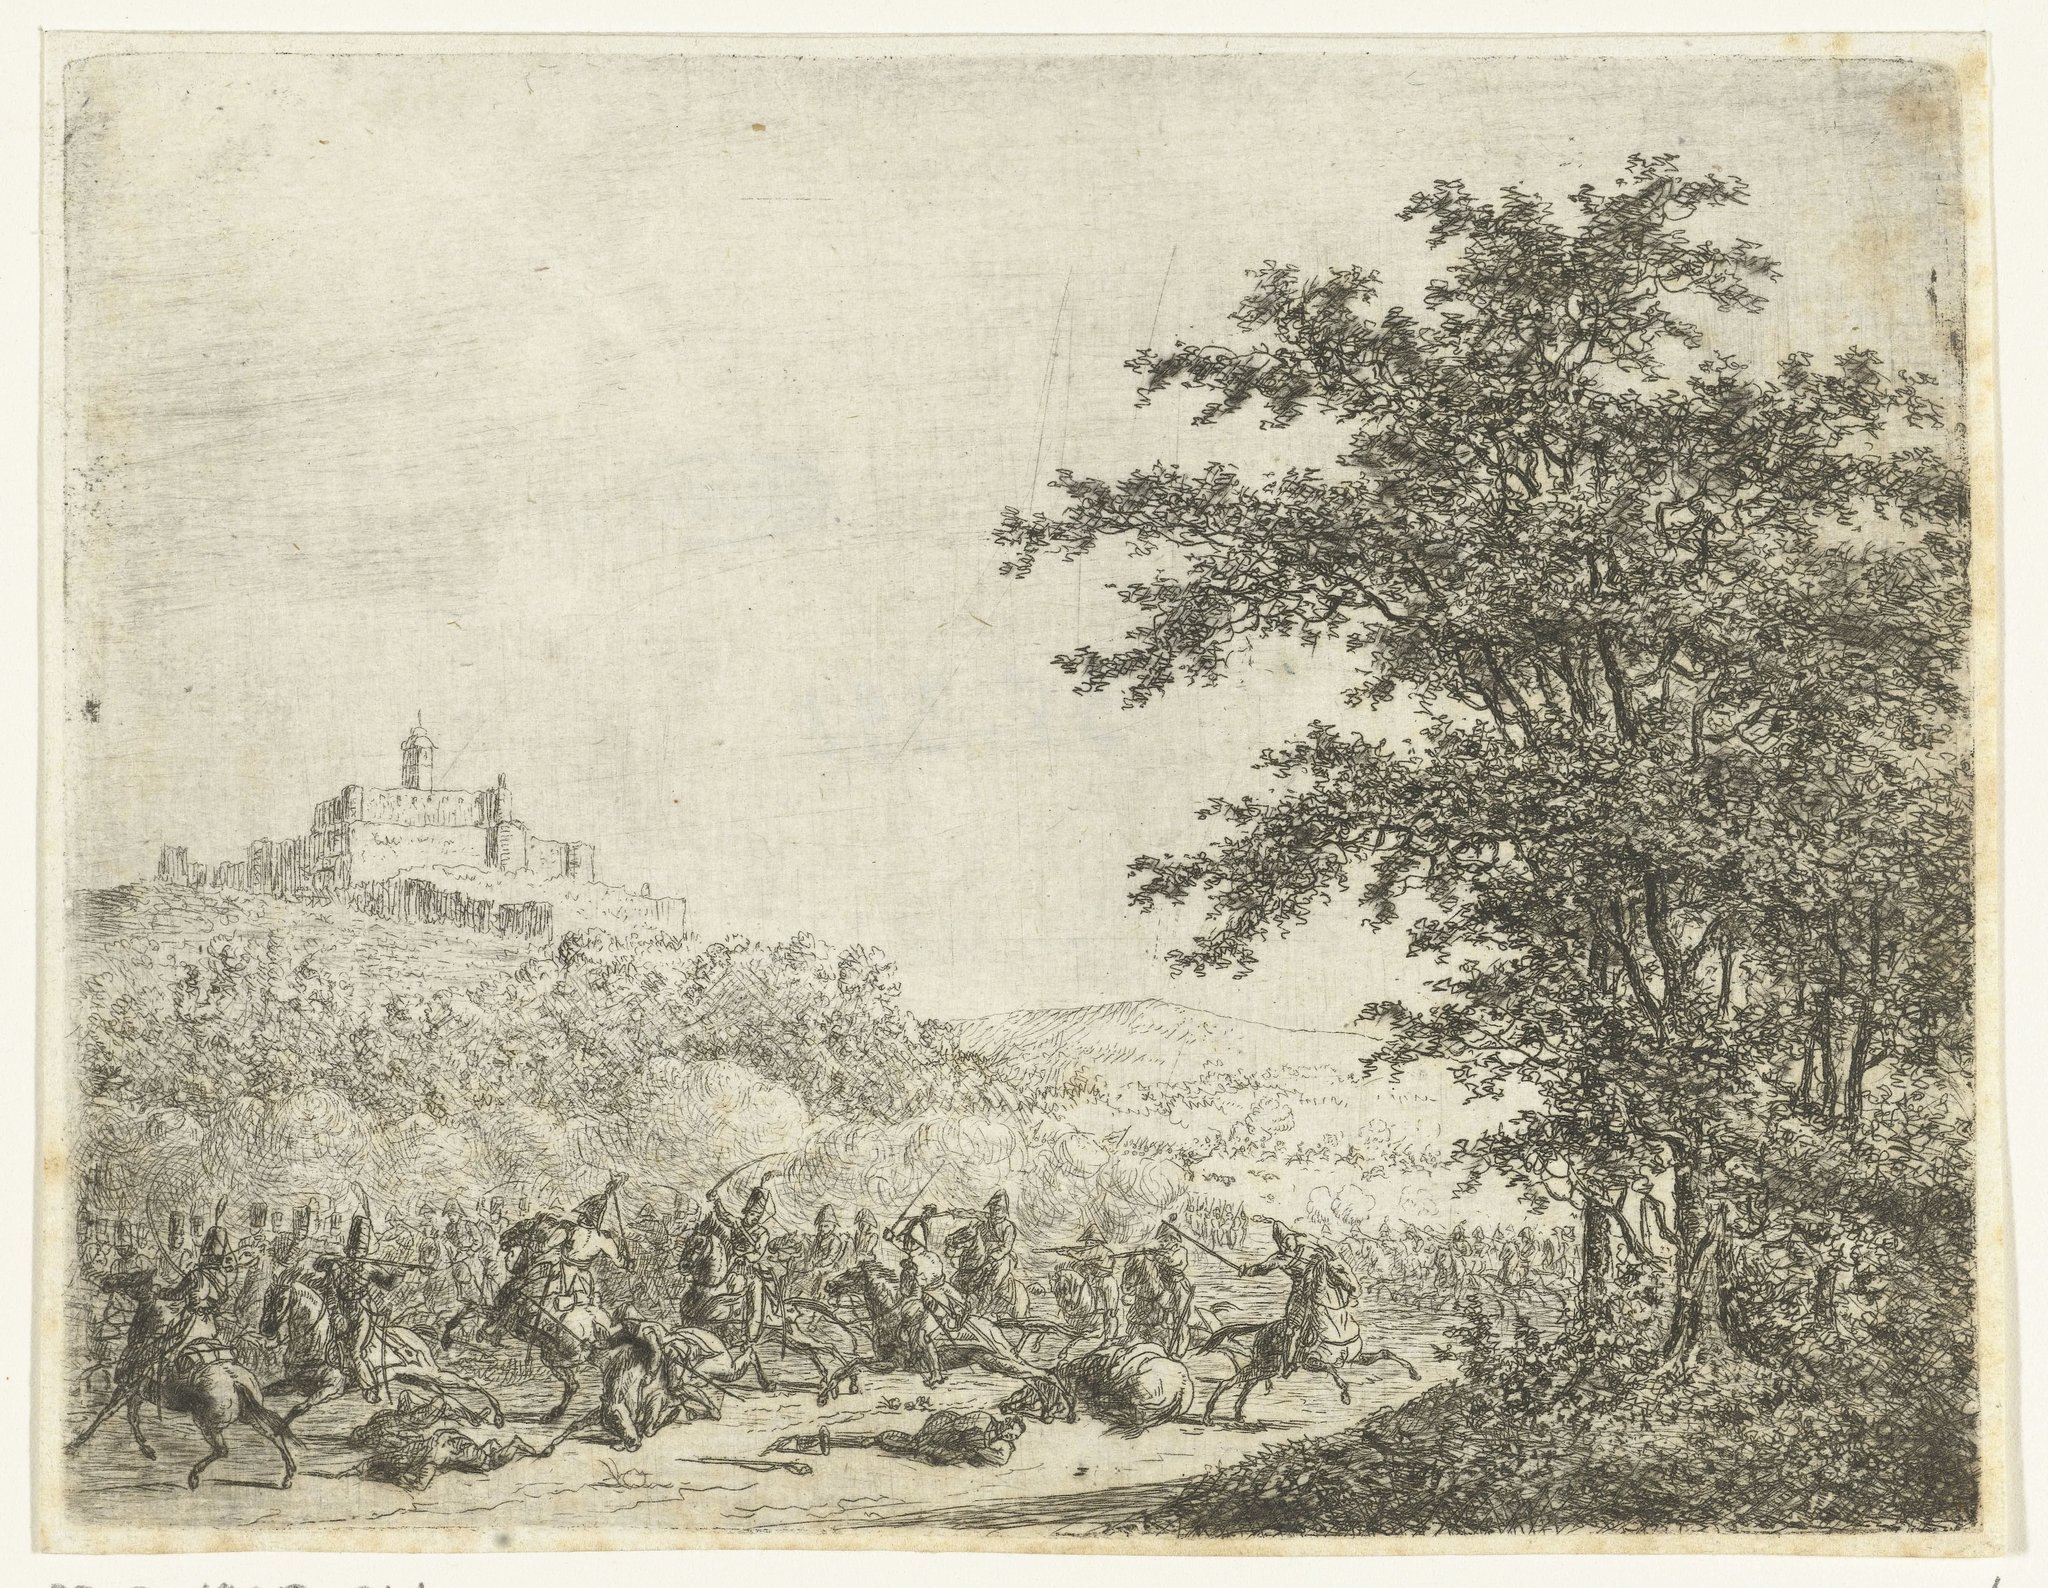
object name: print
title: Cavaleriegevecht bij Würzburg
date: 1798-1837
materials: paper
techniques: etching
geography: netherlands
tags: battle, warfare; military affairs (+ cavalry, horsemen)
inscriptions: collector's mark: Lugt 2228, collector's mark: Lugt 2760